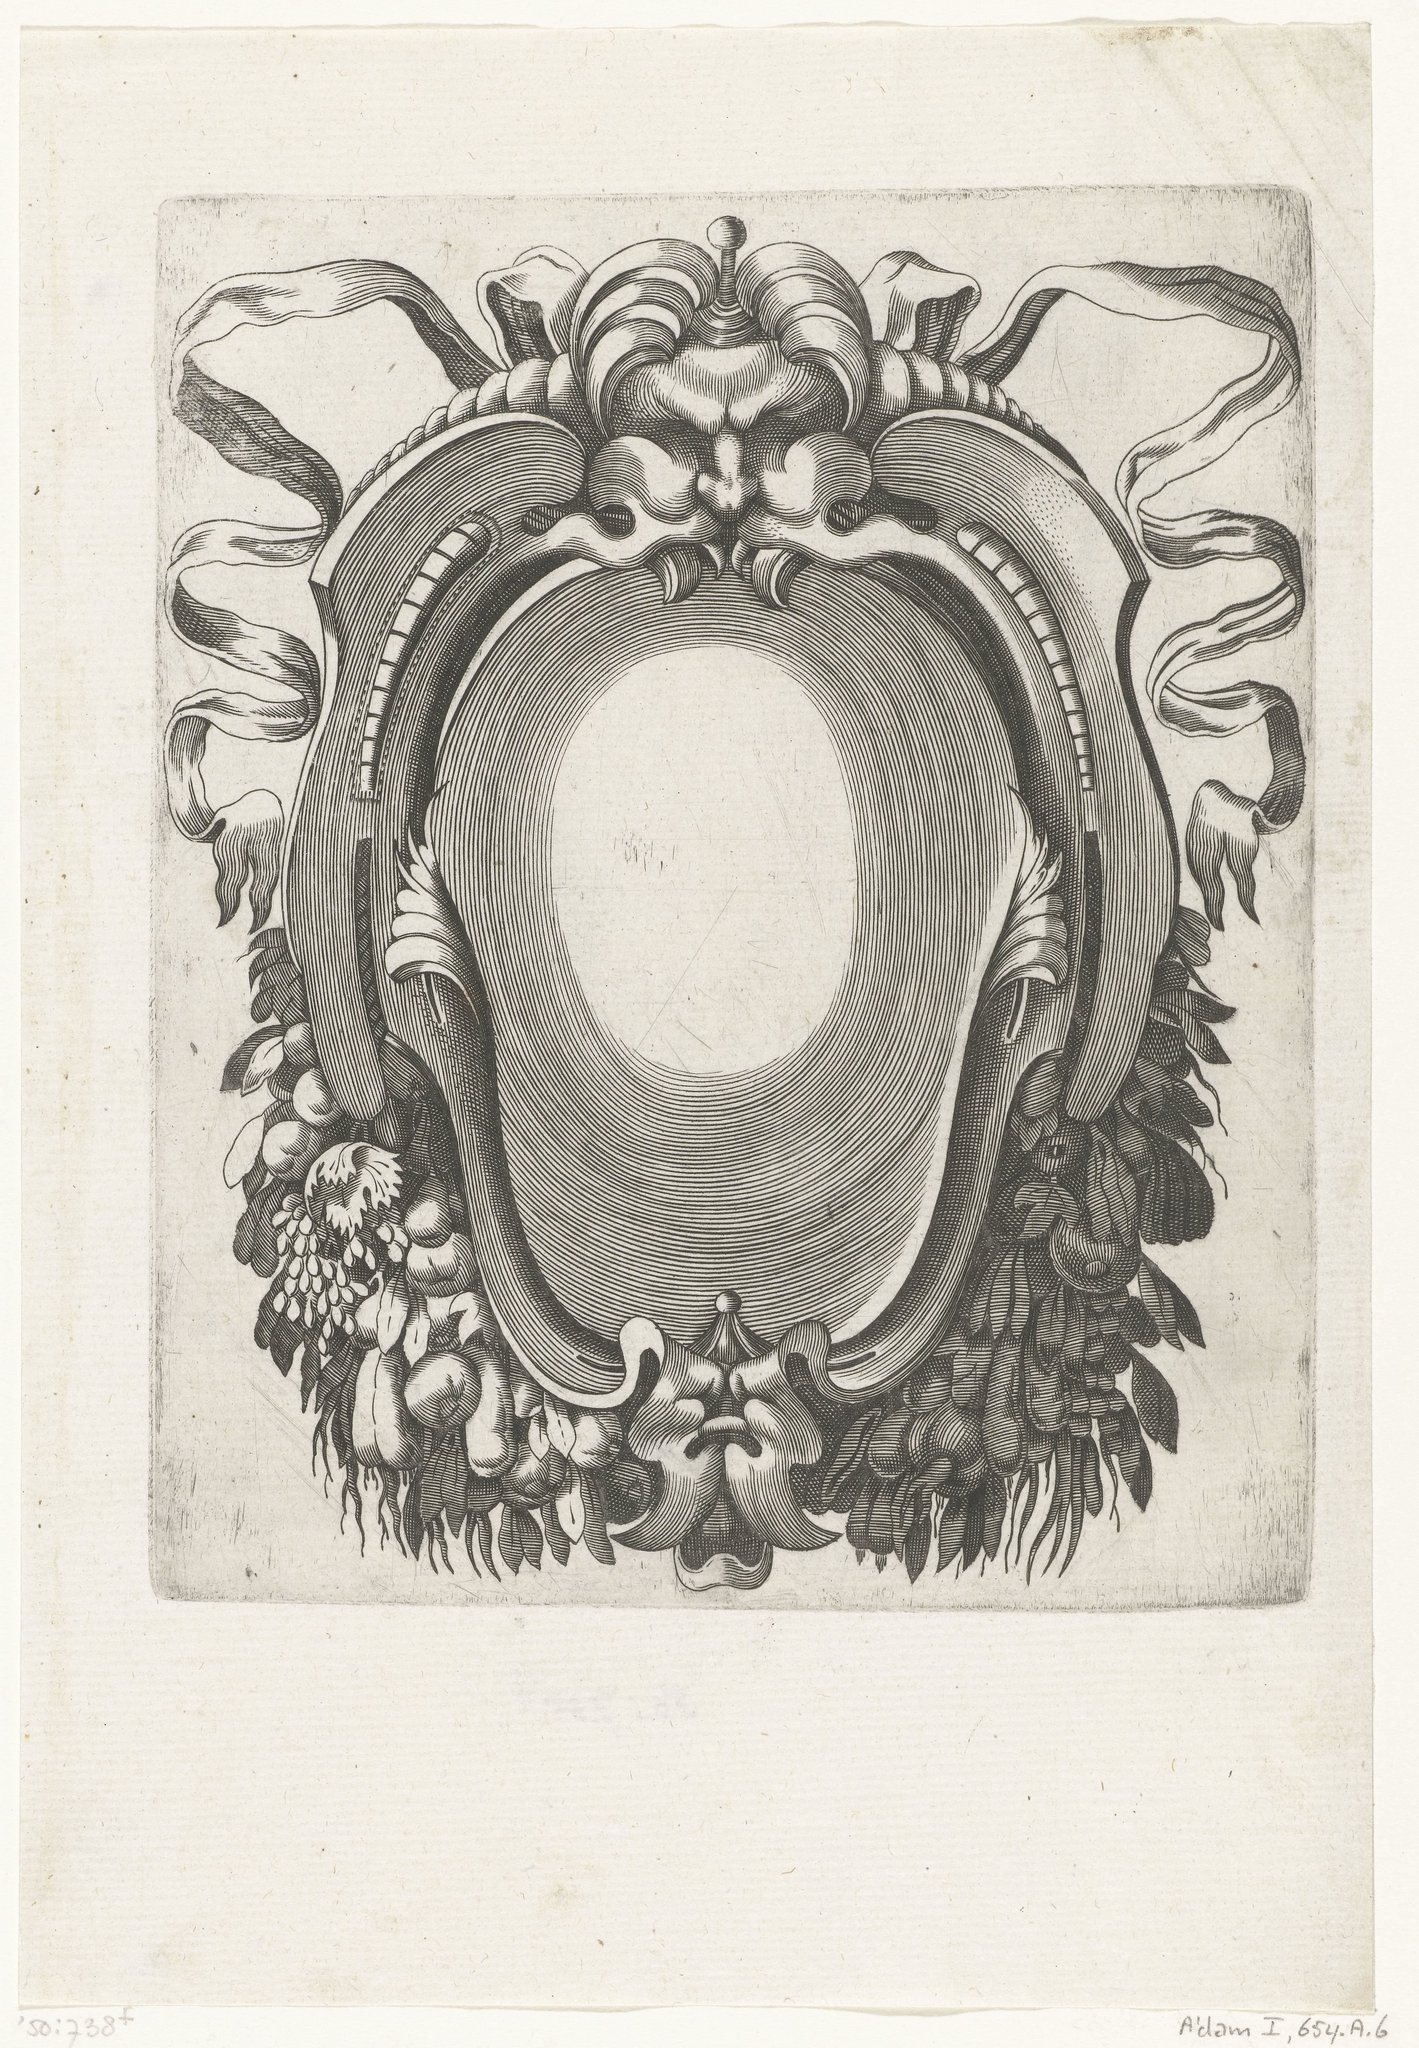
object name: ornament print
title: Cartouche met guirlandes onderaan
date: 1628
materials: paper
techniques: engraving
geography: france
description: Midden boven hangt een mascaron met een knop op het hoofd en linten achter zich.